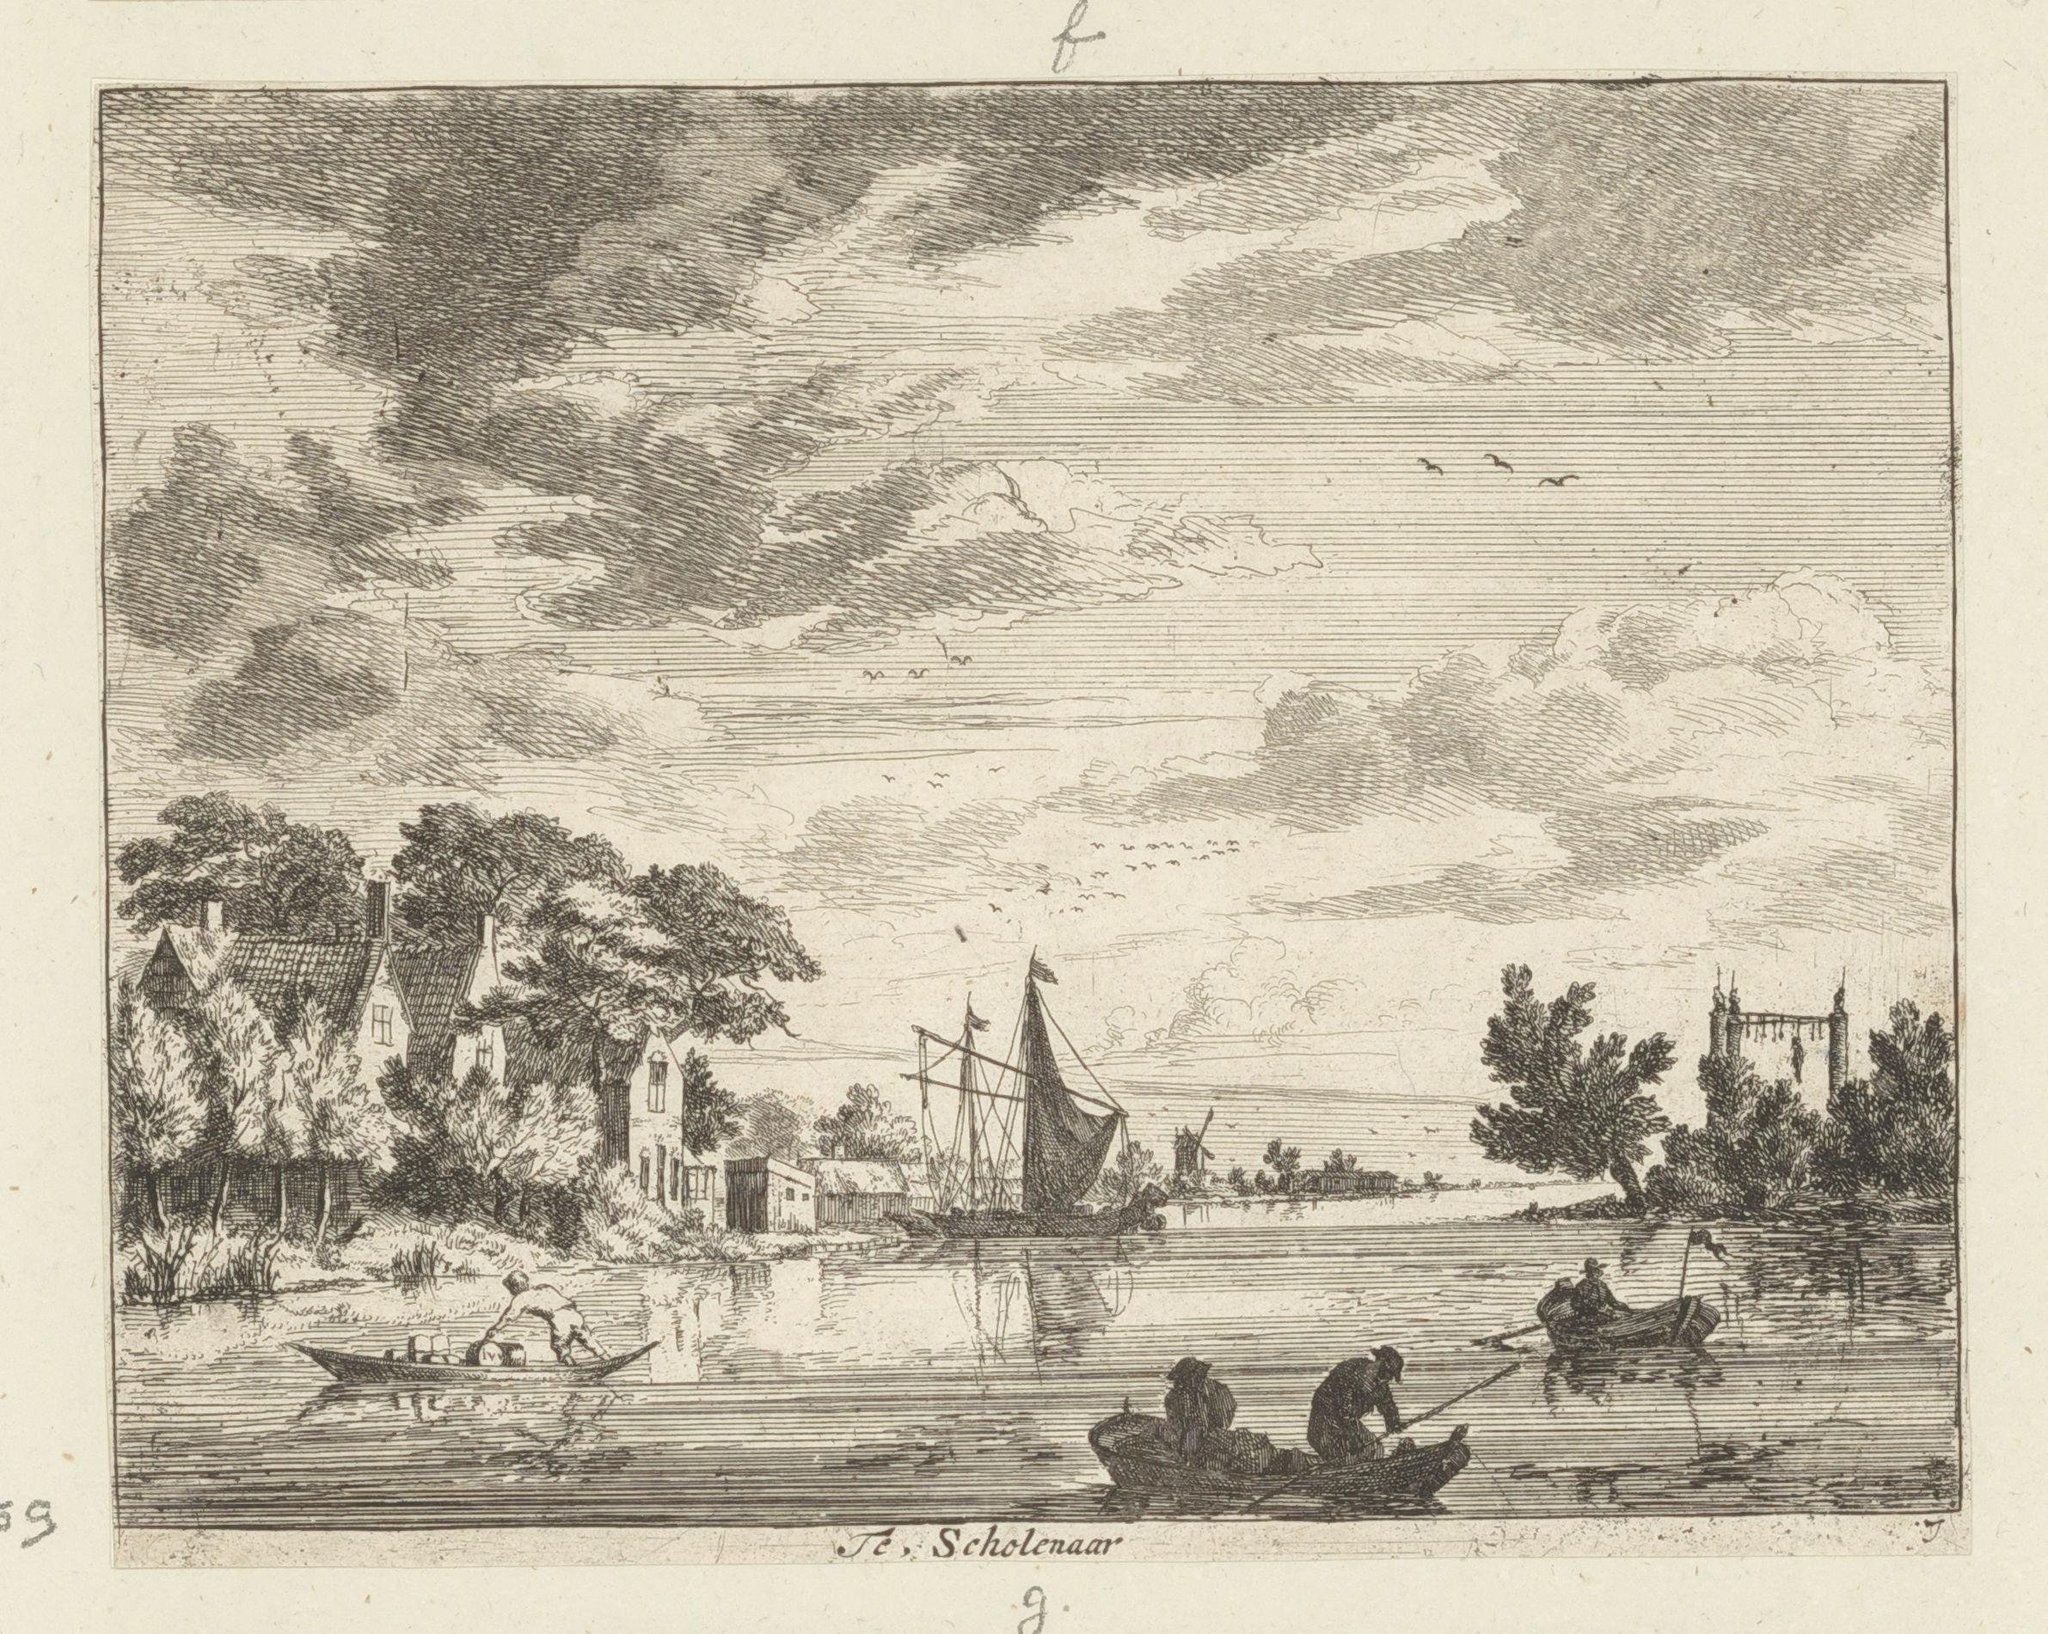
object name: print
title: Te, Scholenaar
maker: jan vincentsz. van der vinne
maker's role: draughtsman, print maker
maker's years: 1663-1721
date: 1688-1690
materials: paper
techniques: engraving, etching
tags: instruments of torture, execution or punishment: gallows, dusk, evening twilight, sailing-ship, sailing-boat, rowing-boat, canoe, etc., haarlem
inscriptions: stamp, collector's mark: Lugt 1641, stamp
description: Drie roeiboten en een zeilschip op een rivier bij een vallende avond. Rechts een galgenveld. Rechtsonder genummerd: 7. Onderwerpsrubrieken binnen de Atlas Zeden en Gewoonten: Handel, nijverheid en verkeer, Buitenleven.